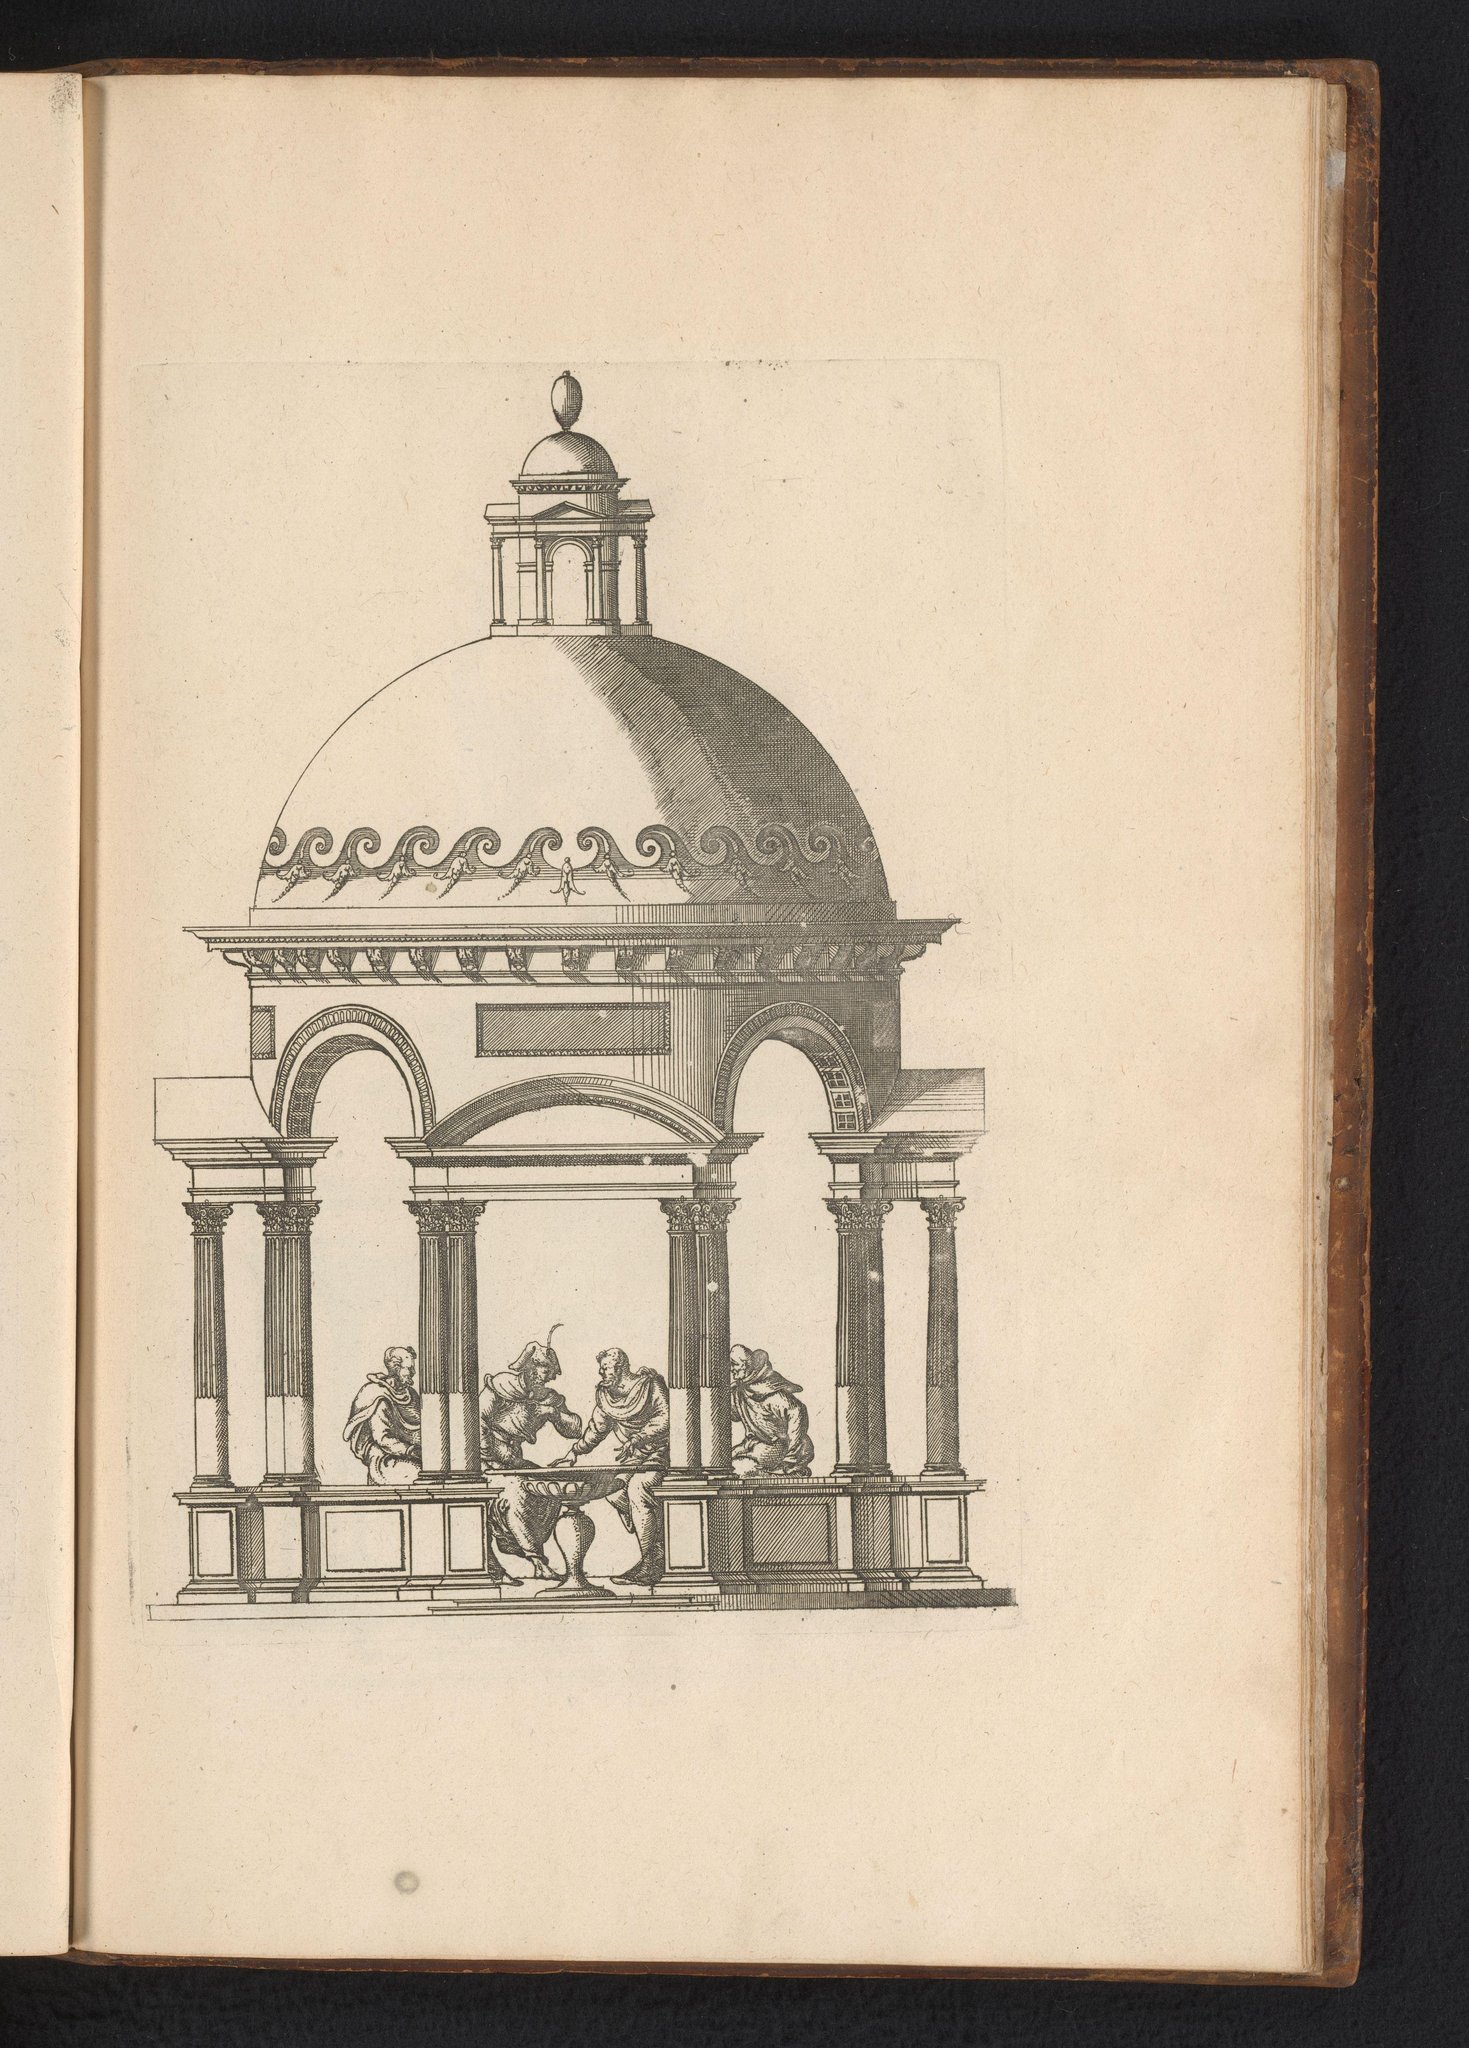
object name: ornament print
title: Gebouw met koepel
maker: jacques androuet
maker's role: draughtsman, print maker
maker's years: 1515-1584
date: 1561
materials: paper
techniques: etching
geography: paris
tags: architectural design or model, dome ~ architecture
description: Gebouw met koepel, met vier mannen. Onderdeel van 'Seconde livre d'architectvre' (1561): 64 etsen met geornamenteerde architectuuronderdelen.